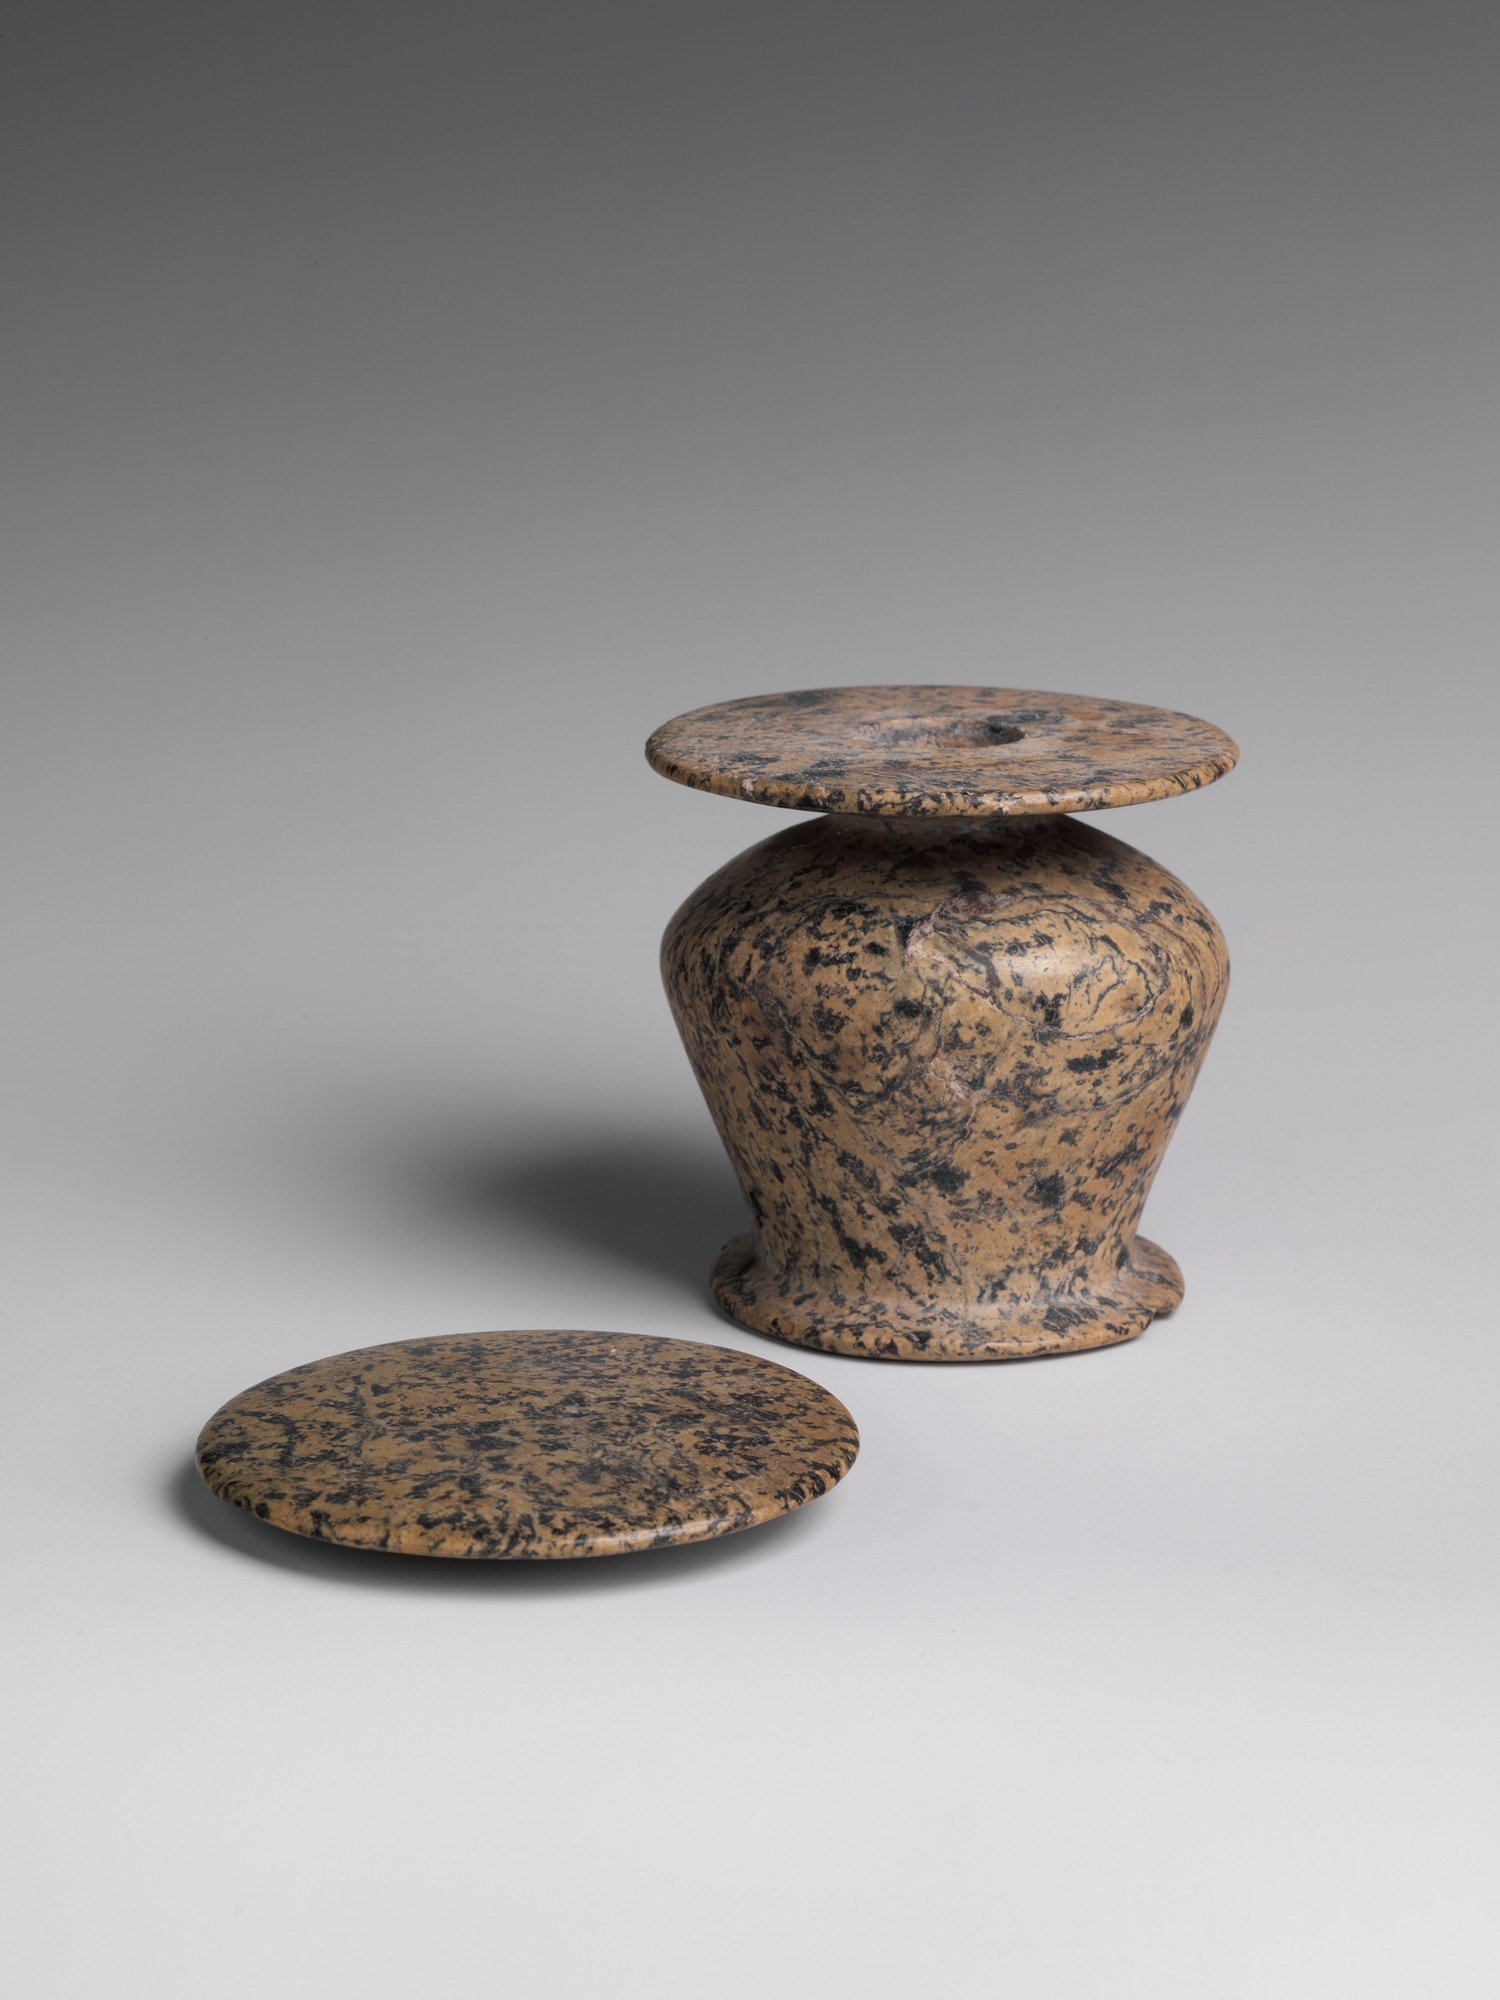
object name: kohl jar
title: Kohl jar with lid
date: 1635-1458 BCE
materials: stone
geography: egypt